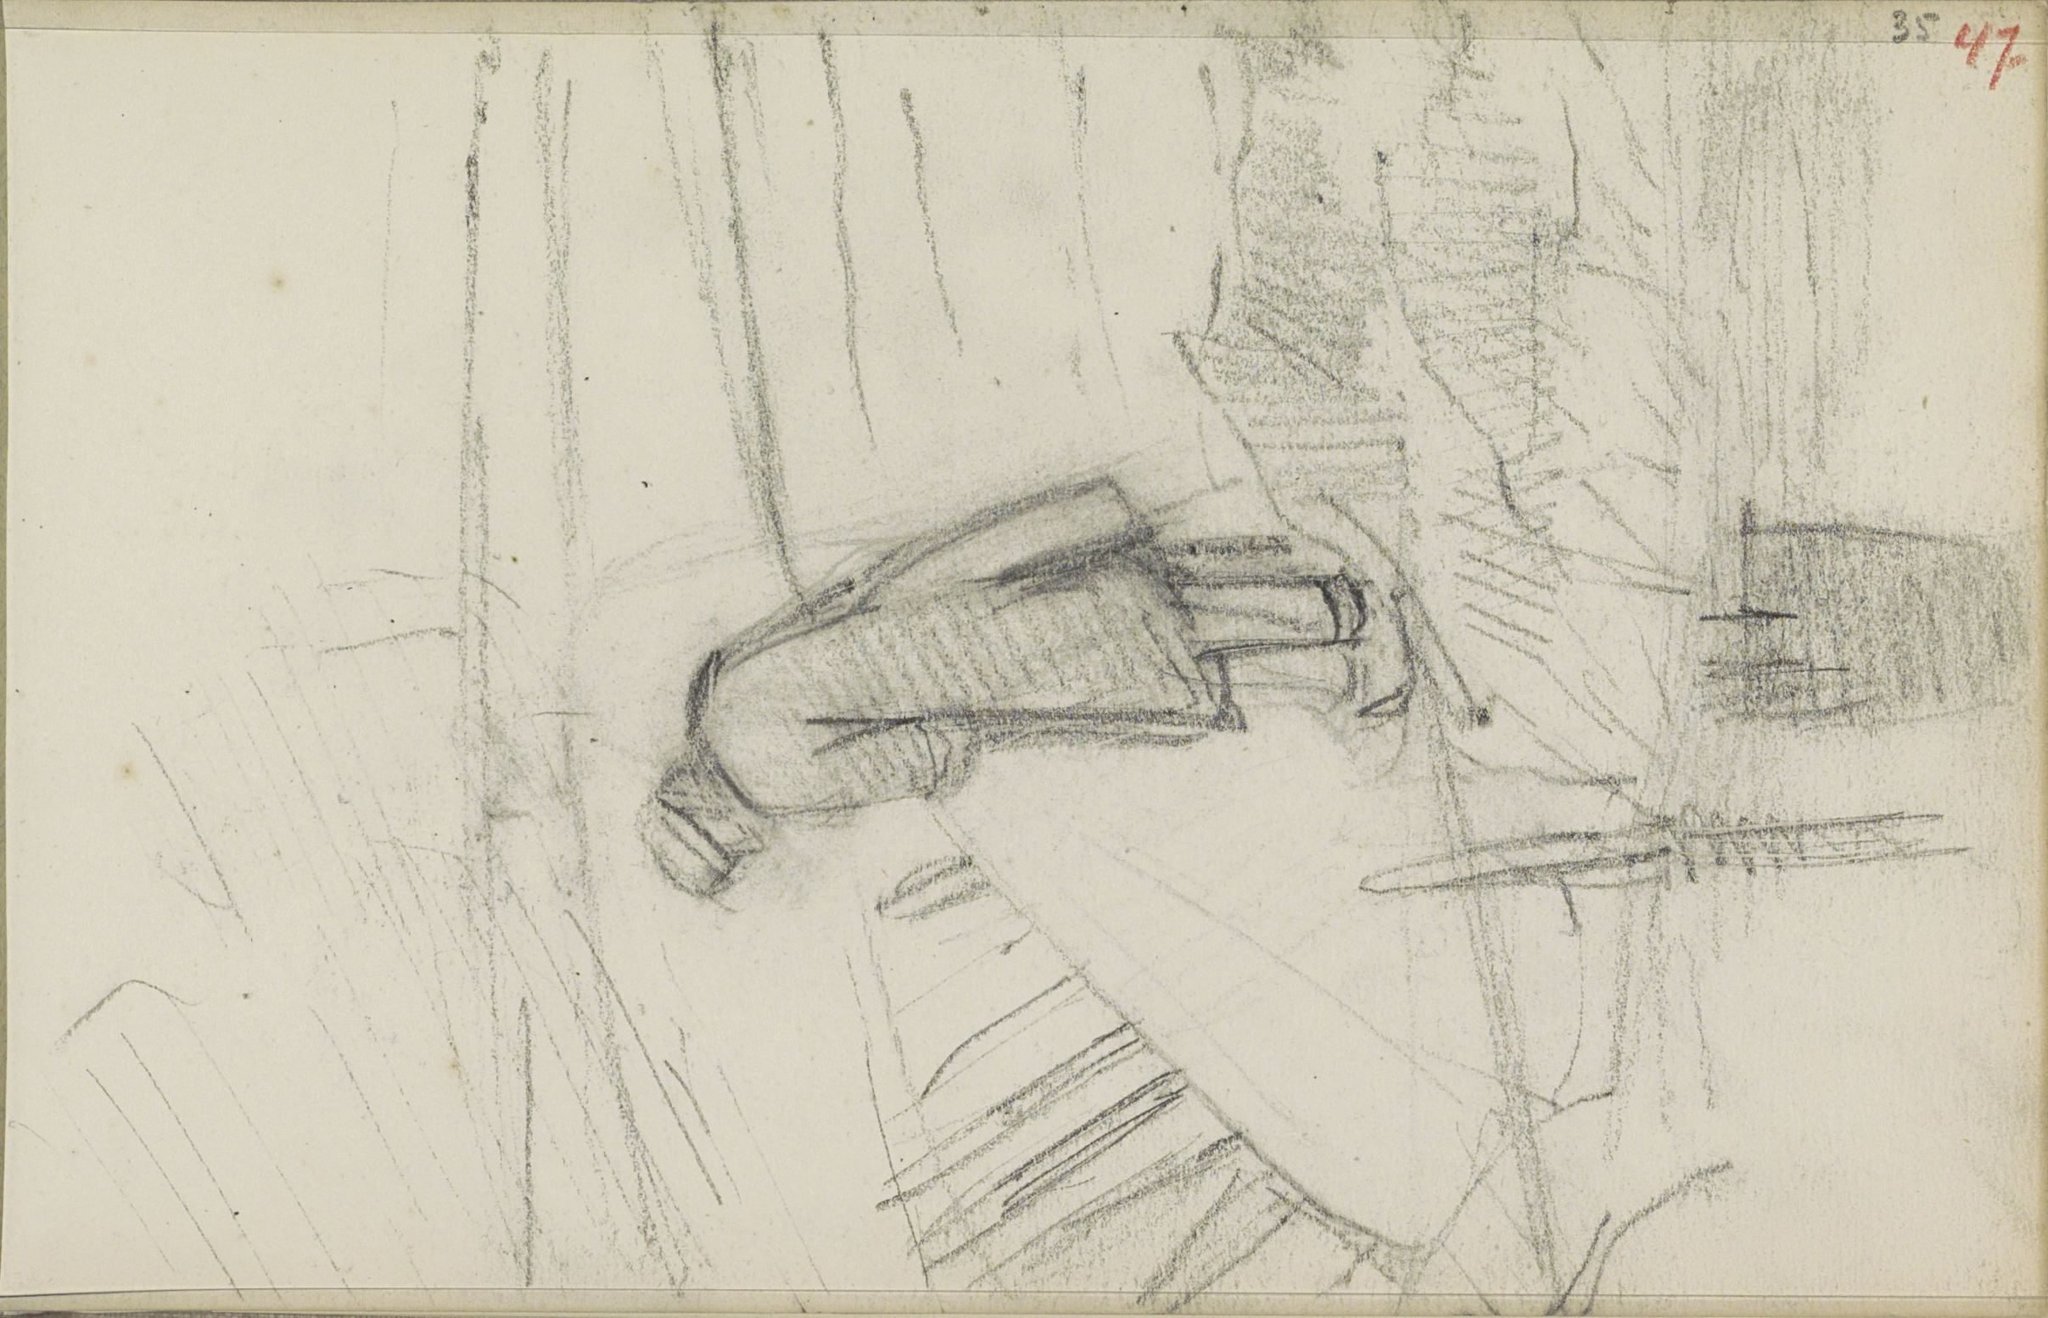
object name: sketchbook leaf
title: Staande man aan een waterkant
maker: jozef israëls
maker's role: draughtsman, painter, print maker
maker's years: 1824-1911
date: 1834-1911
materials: paper, pencil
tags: landscapes with waters, waterscapes, seascapes (in the temperate zone) (+ landscape with figures, staffage)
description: De man draagt een hoed, klompen en een lange jas. Blad 35 recto uit een schetsboek met 37 bladen.